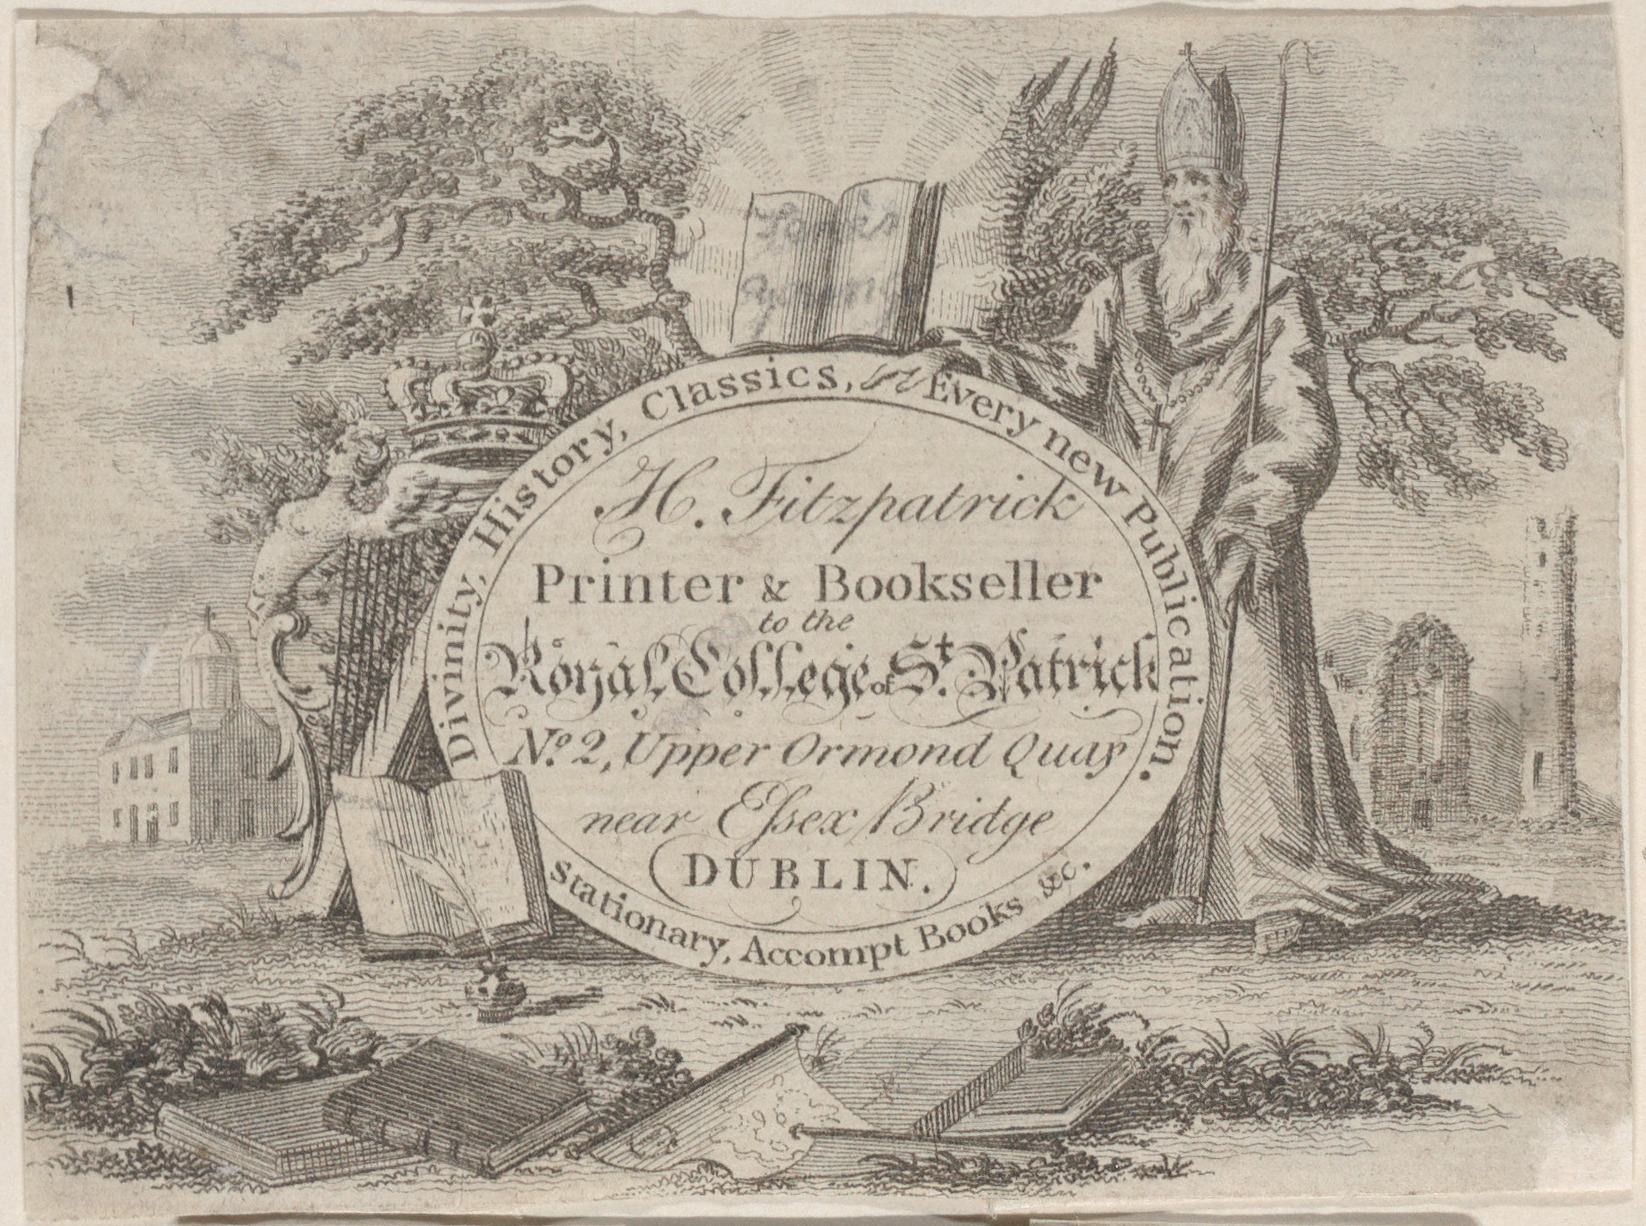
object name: print, trade card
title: Trade Card for H. Fitzpatrick, Printer and Bookseller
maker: anonymous, irish, 19th century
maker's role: artist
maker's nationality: irish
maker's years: 1800-1900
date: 1801-1900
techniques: engraving